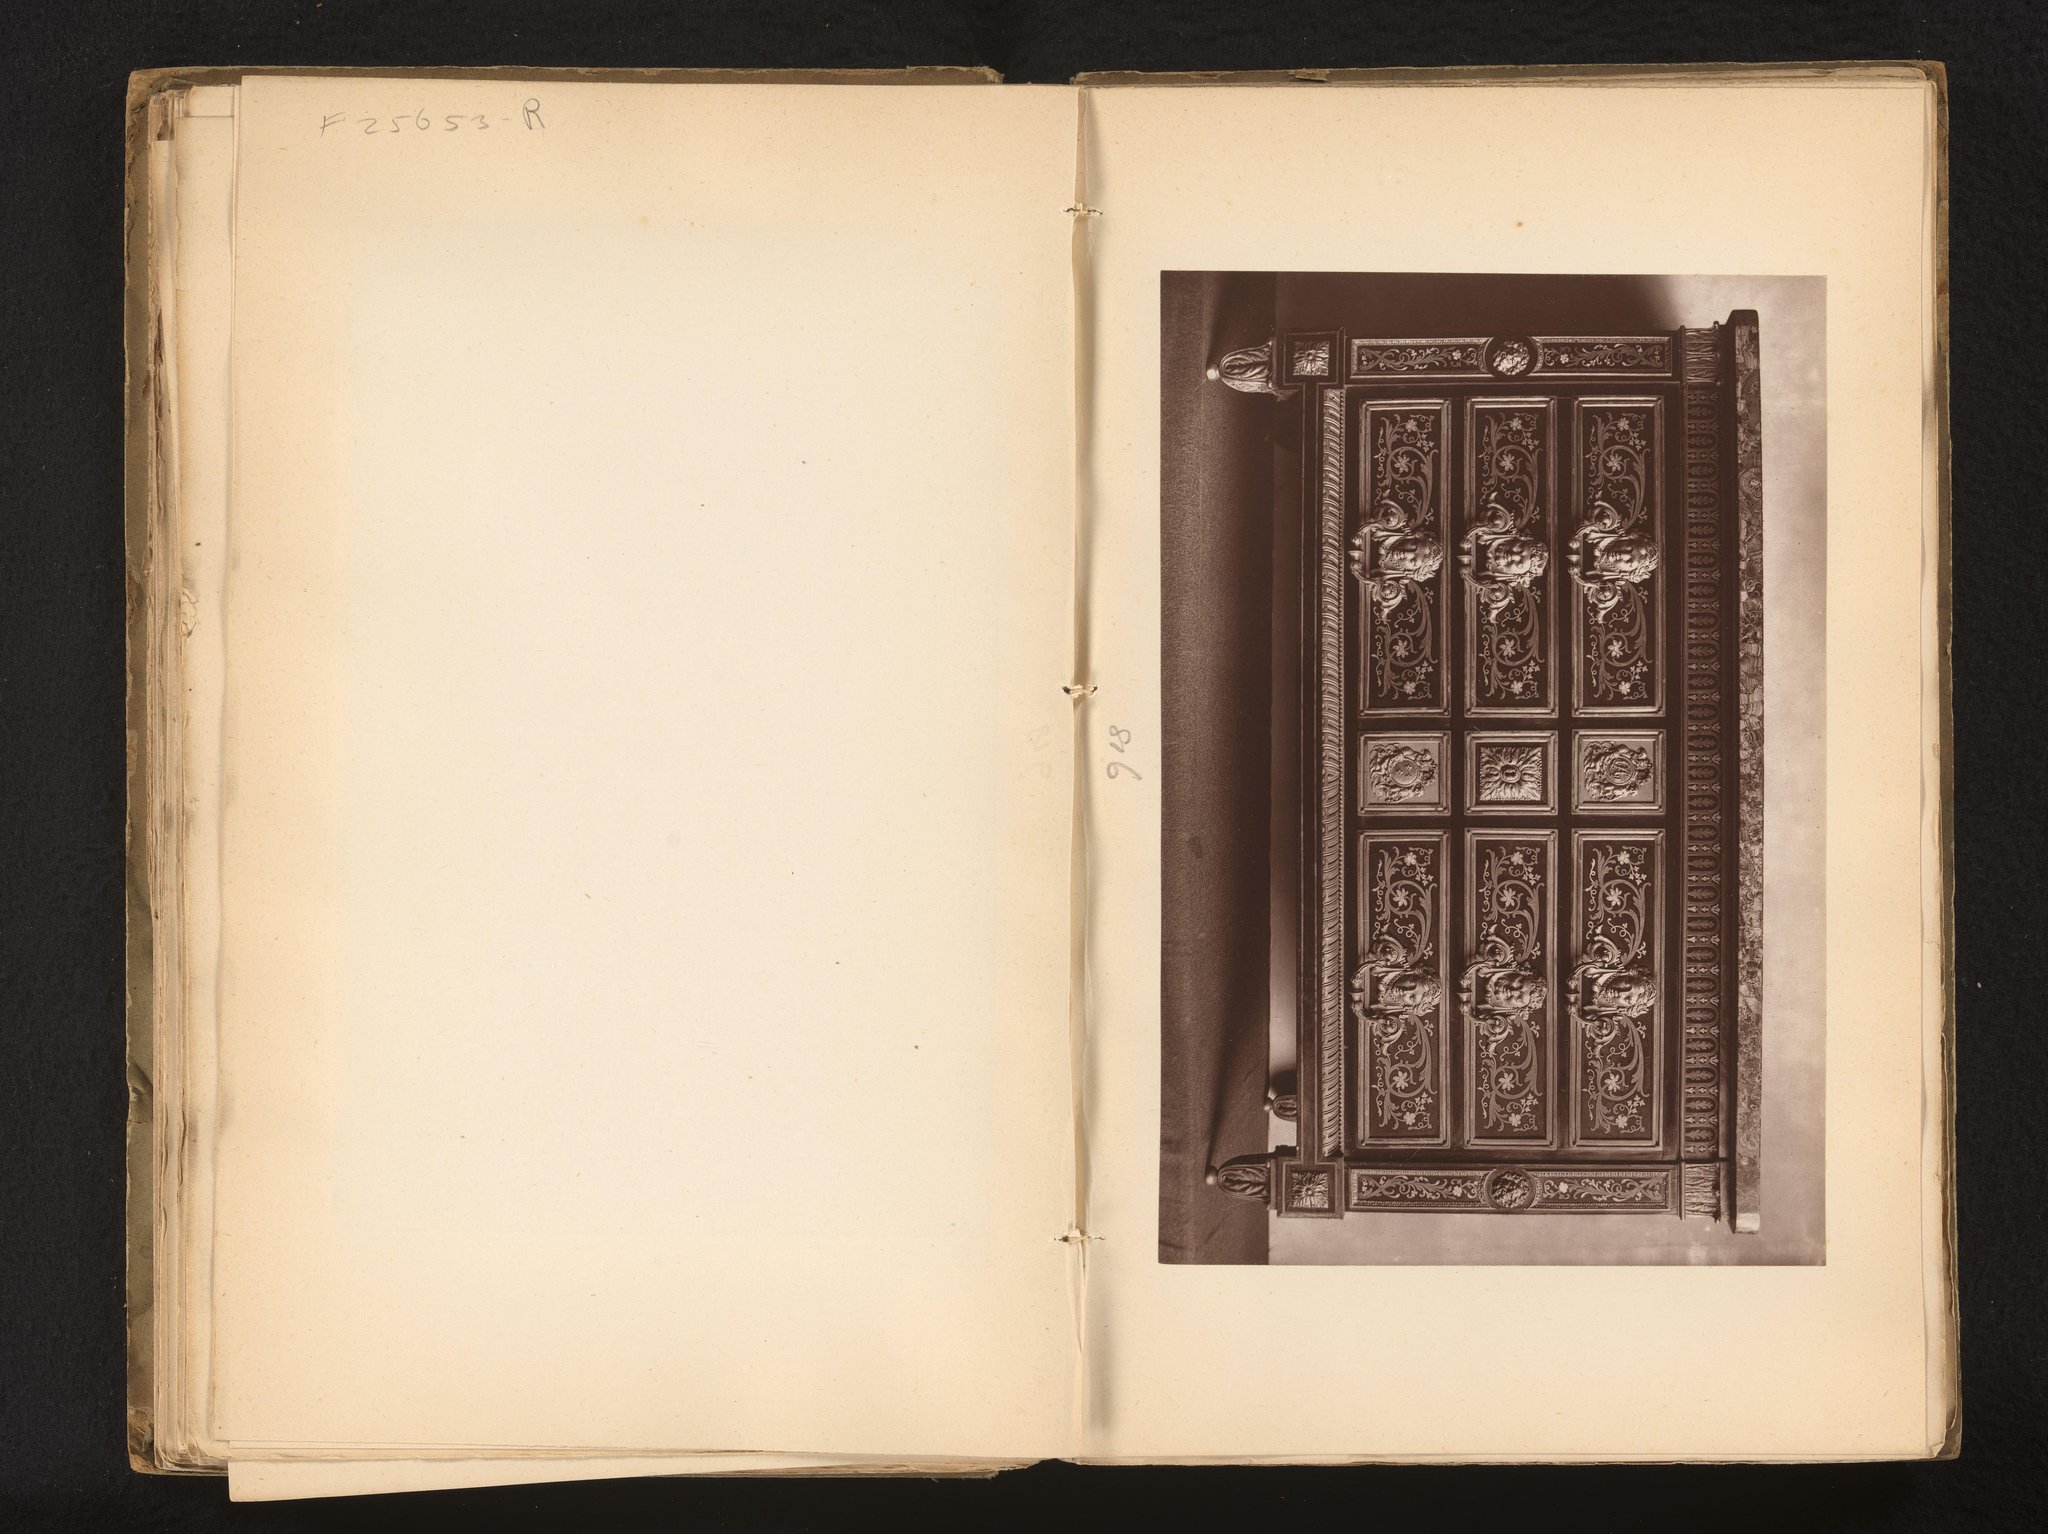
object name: page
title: Gedecoreerde ladekast in de stijl van Lodewijk XIV, uit de collectie van Christopher Beckett Denison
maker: Anonymous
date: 1880-1885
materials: paper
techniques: woodburytype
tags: ornamental cupboard (+ wood and other phytogenic material)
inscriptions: number: ‘816’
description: Prent op elfde ongenummerde pagina na pagina 80.